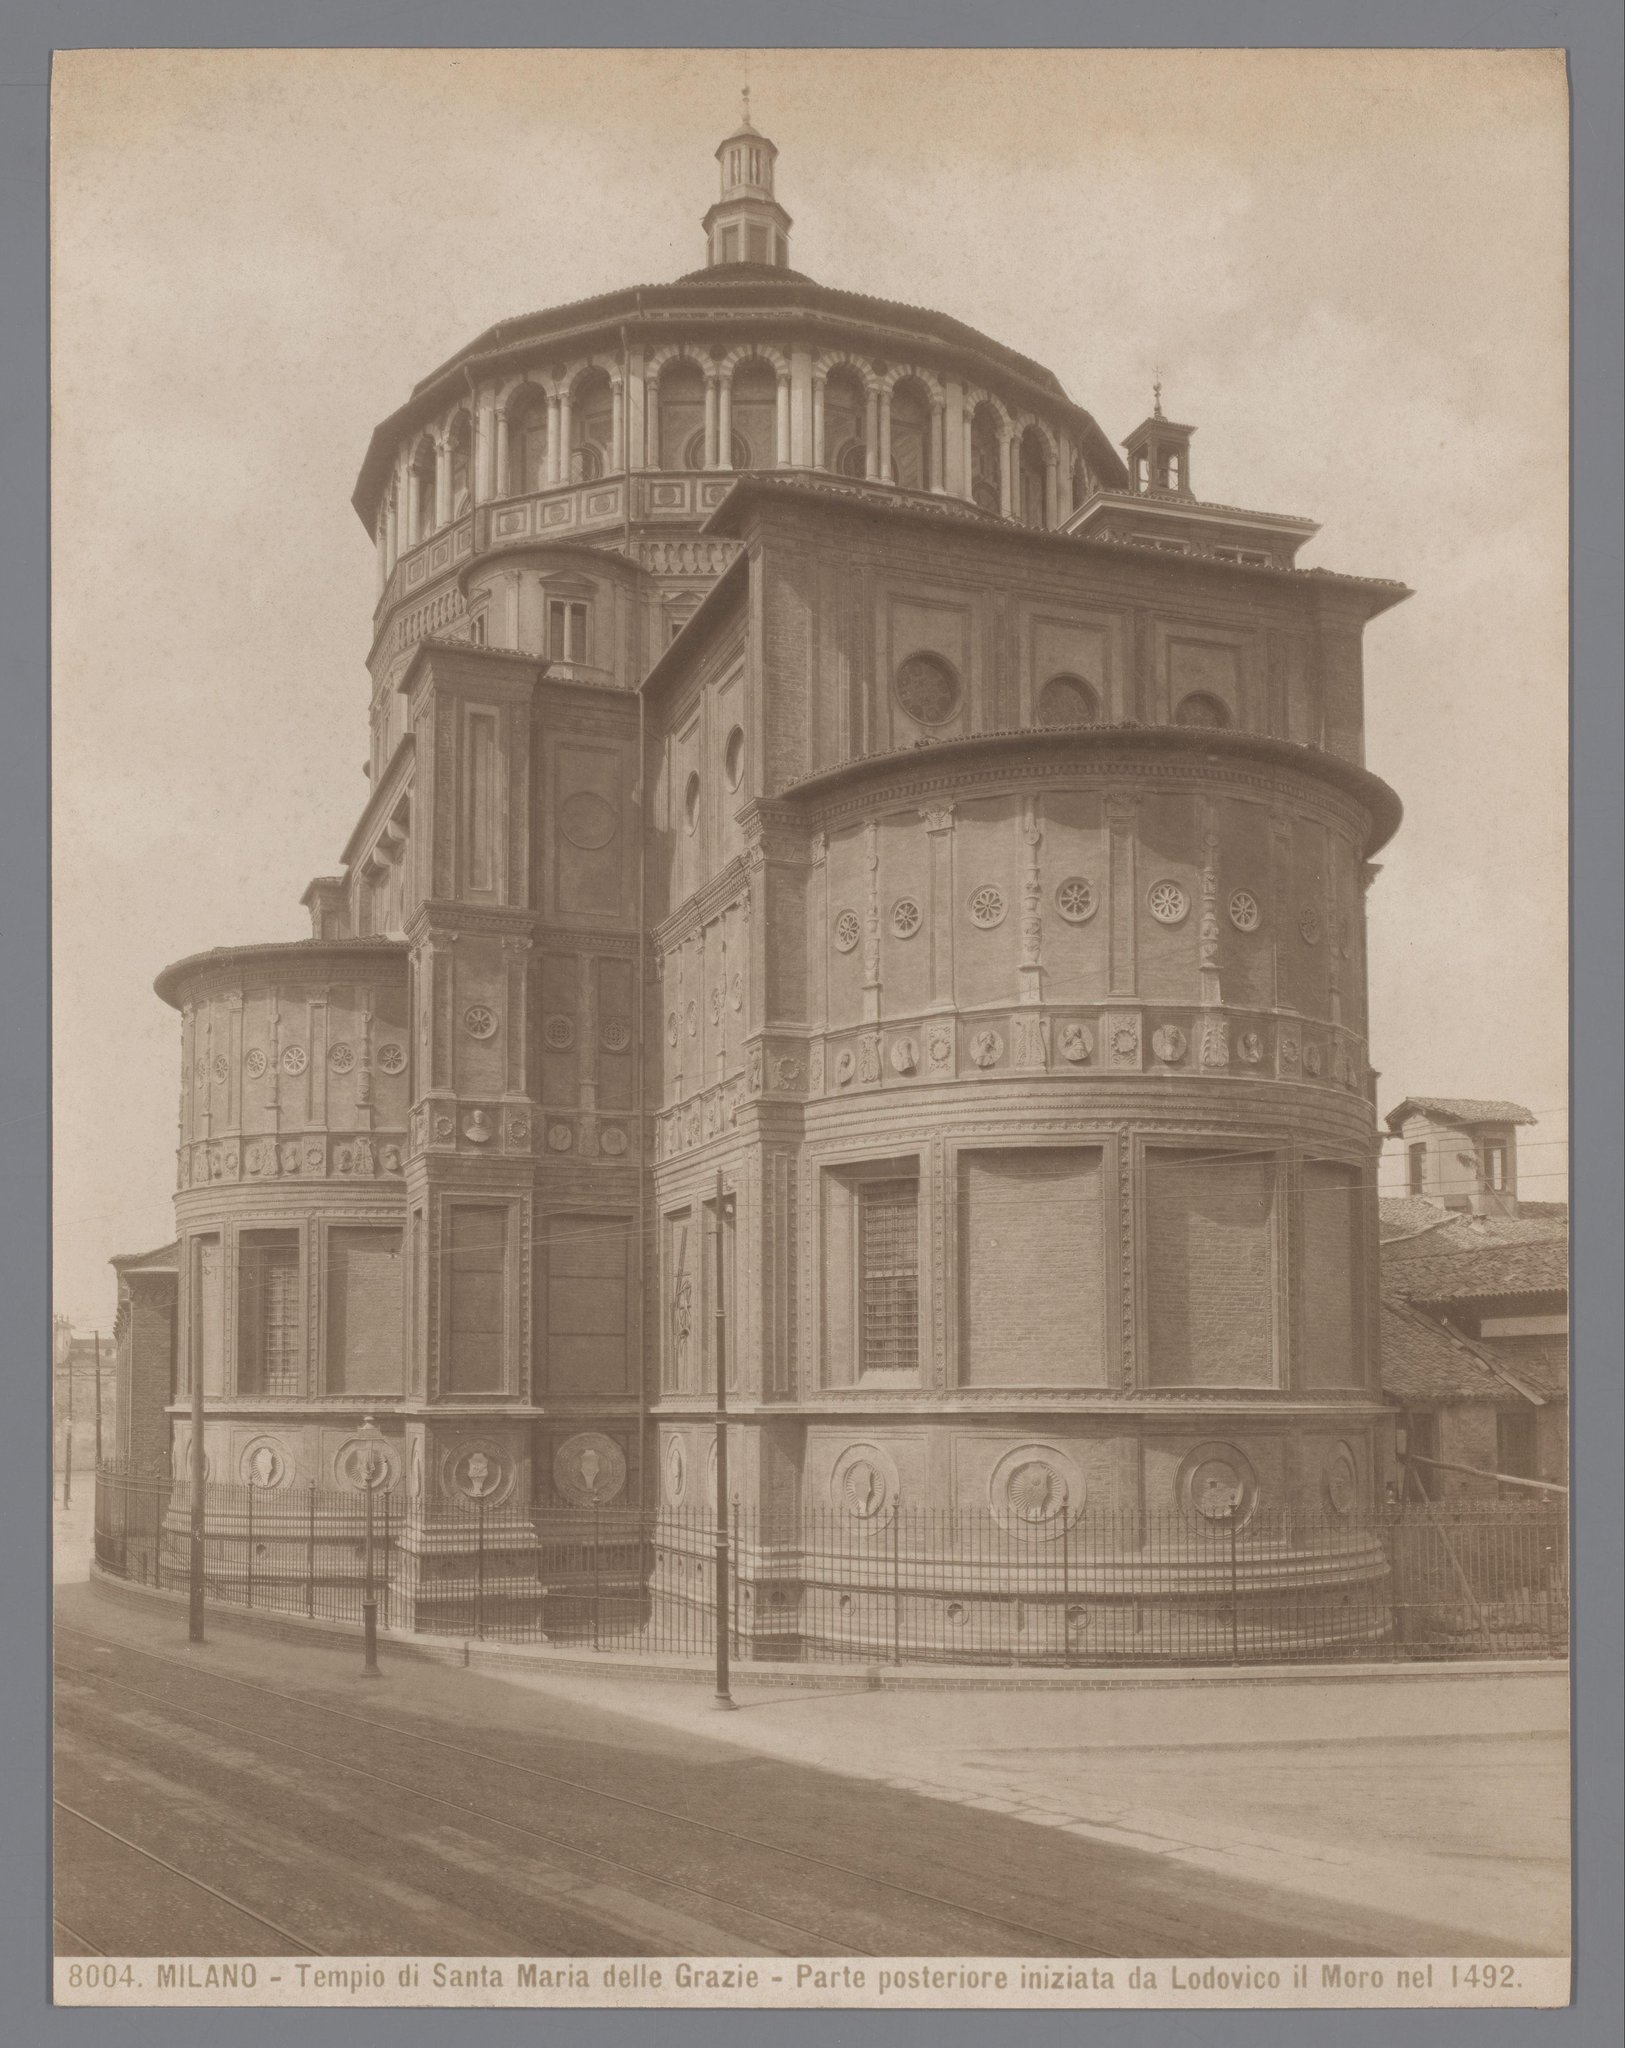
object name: photograph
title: Tempio di Santa Maria delle Grazie - Parte posteriore iniziata da Lodovico il Moro nel 1492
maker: giacomo brogi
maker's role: fotograaf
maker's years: 1822-1881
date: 1890-1920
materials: paper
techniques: gelatin silver print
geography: florence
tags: parts of church interior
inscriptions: number: ‘8004.’, collector's mark: ‘VOSMAER’